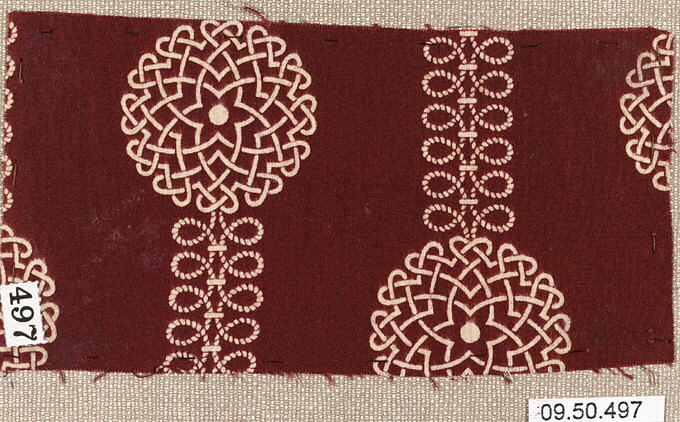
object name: piece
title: Piece (one of 13)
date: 1801-1900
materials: cotton